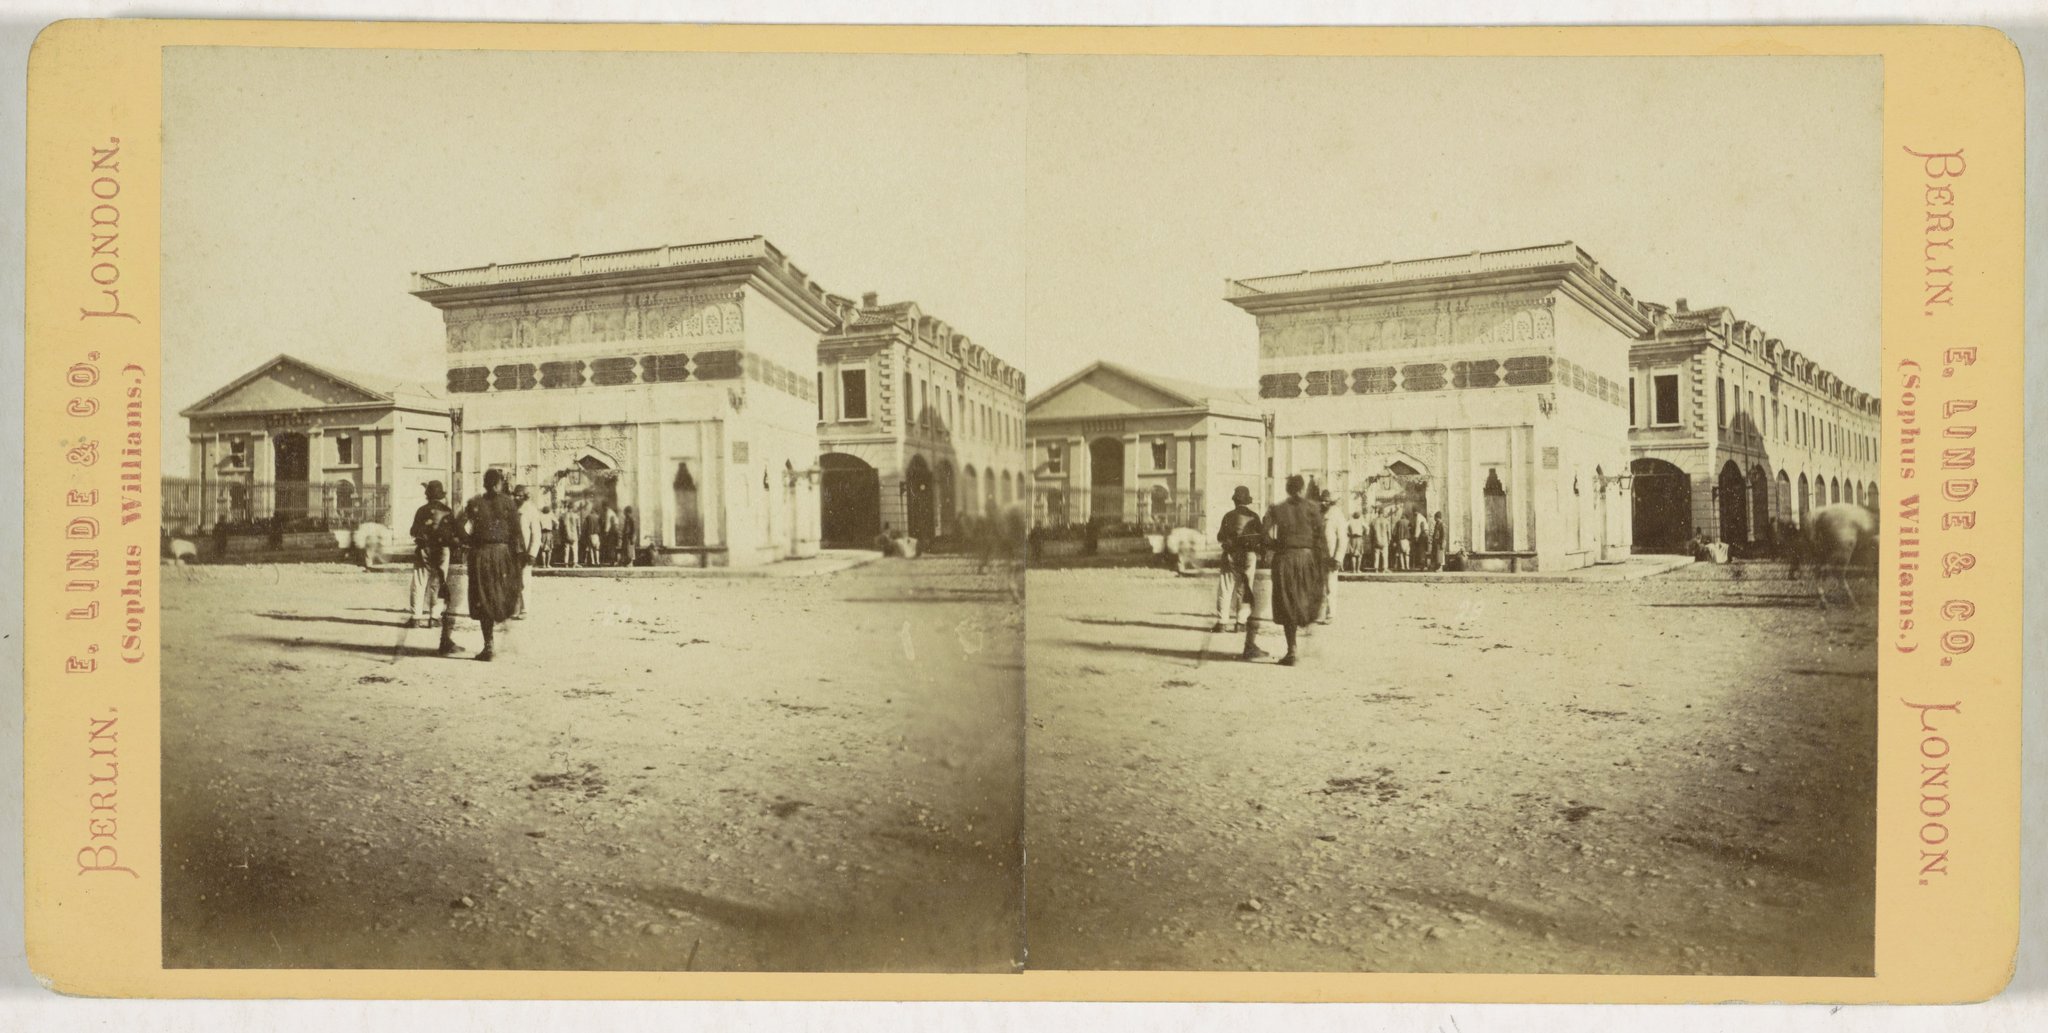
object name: stereograph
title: Brunnen von Top-Khana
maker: Anonymous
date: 1873-1890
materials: cardboard, paper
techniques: albumen print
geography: berlin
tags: utilitarian, public pump or water fountain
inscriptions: number: ‘29’